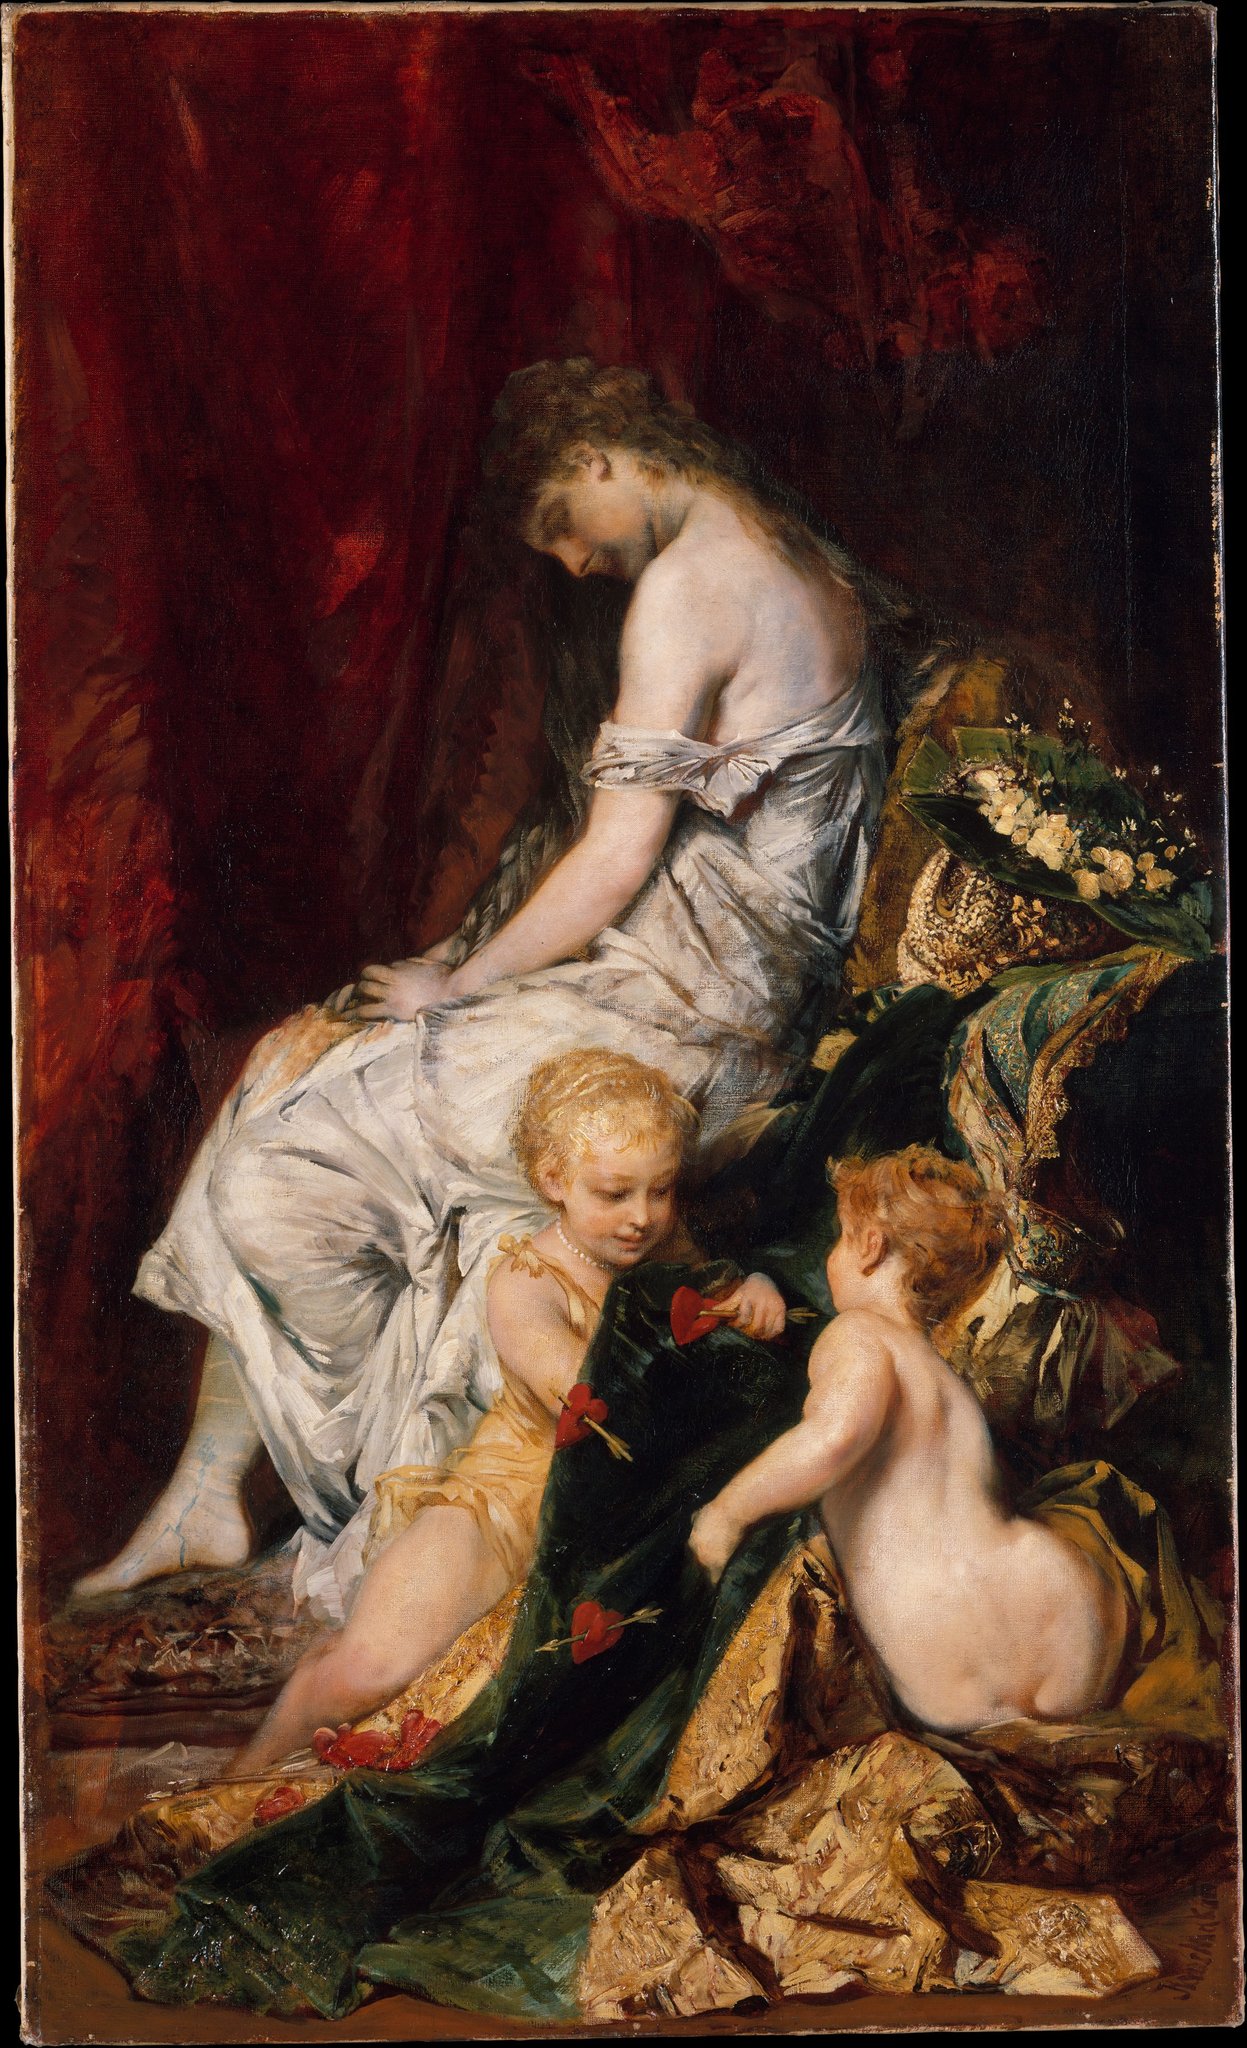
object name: painting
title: The Dream after the Ball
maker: hans makart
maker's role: artist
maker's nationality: austrian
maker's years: 1840-1884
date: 1860-1884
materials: canvas, oil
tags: girls,women